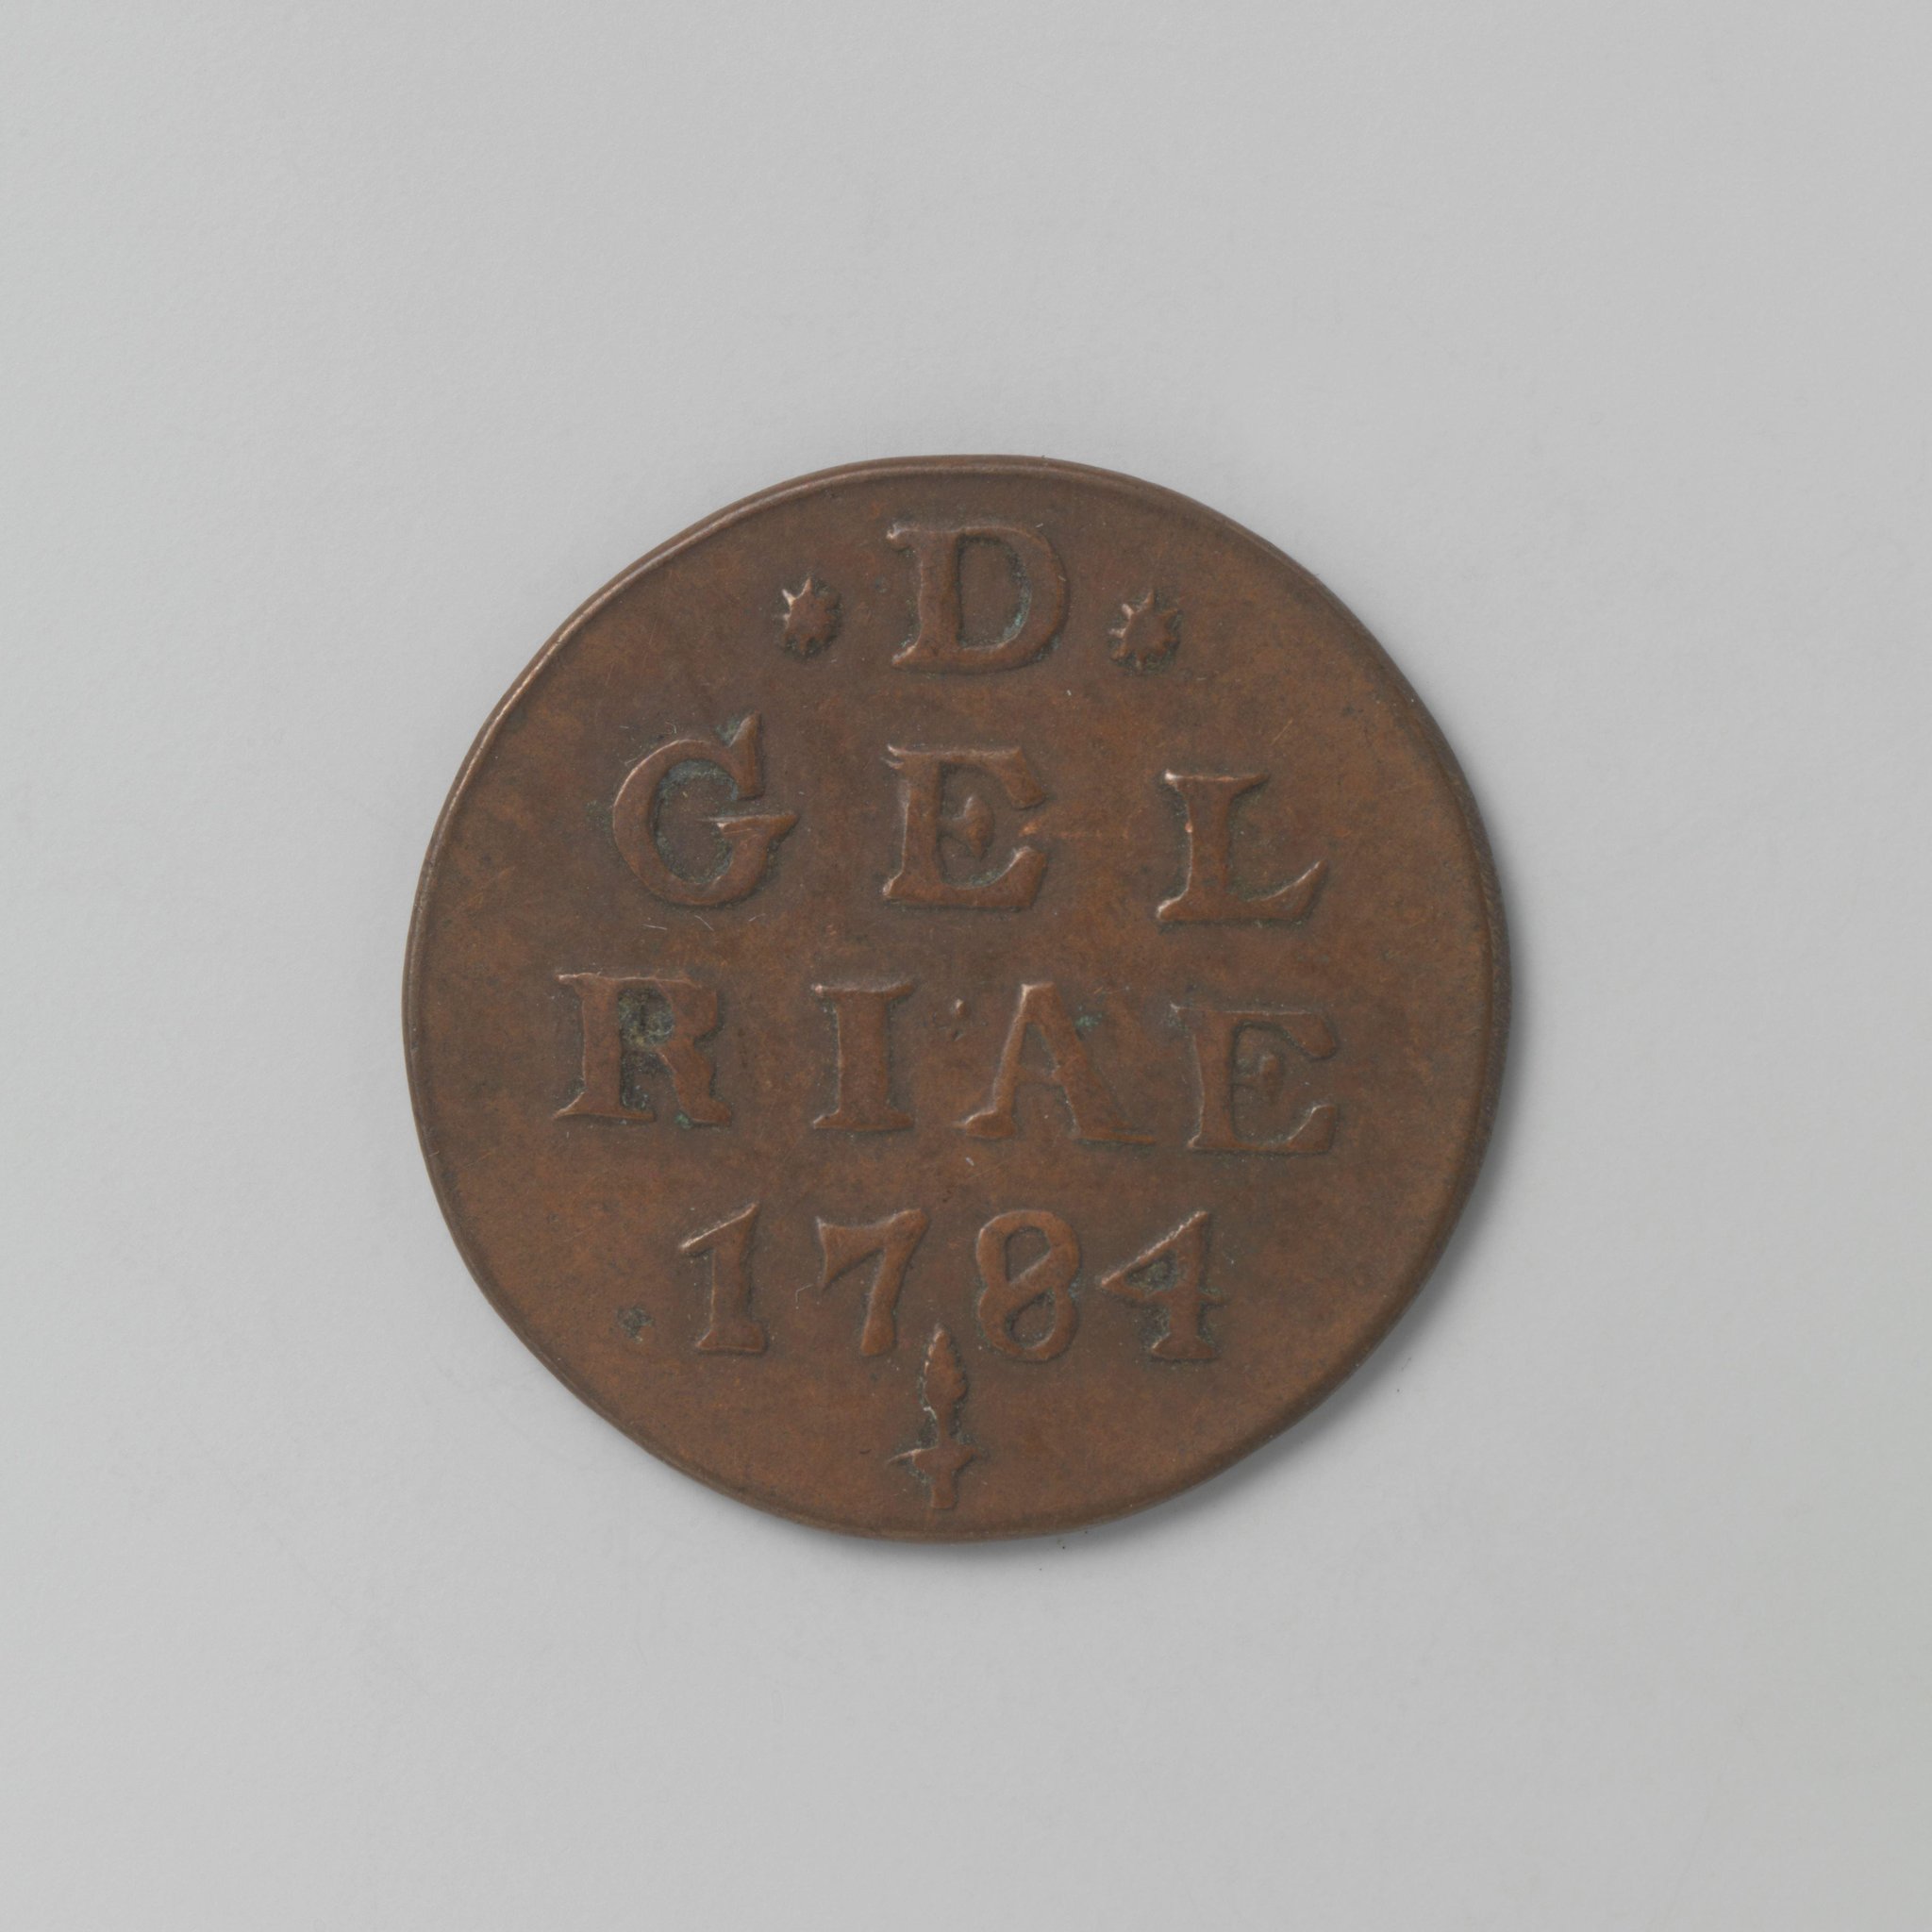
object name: duit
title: Gelderland, duit, 1784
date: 1784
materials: copper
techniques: striking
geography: harderwijk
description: Koperen munt. Voorzijde: in drie regels D/GEL/RIAE, daaronder jaartal en muntmeesterteken. Keerzijde: gekroond Gelders wapenschild.